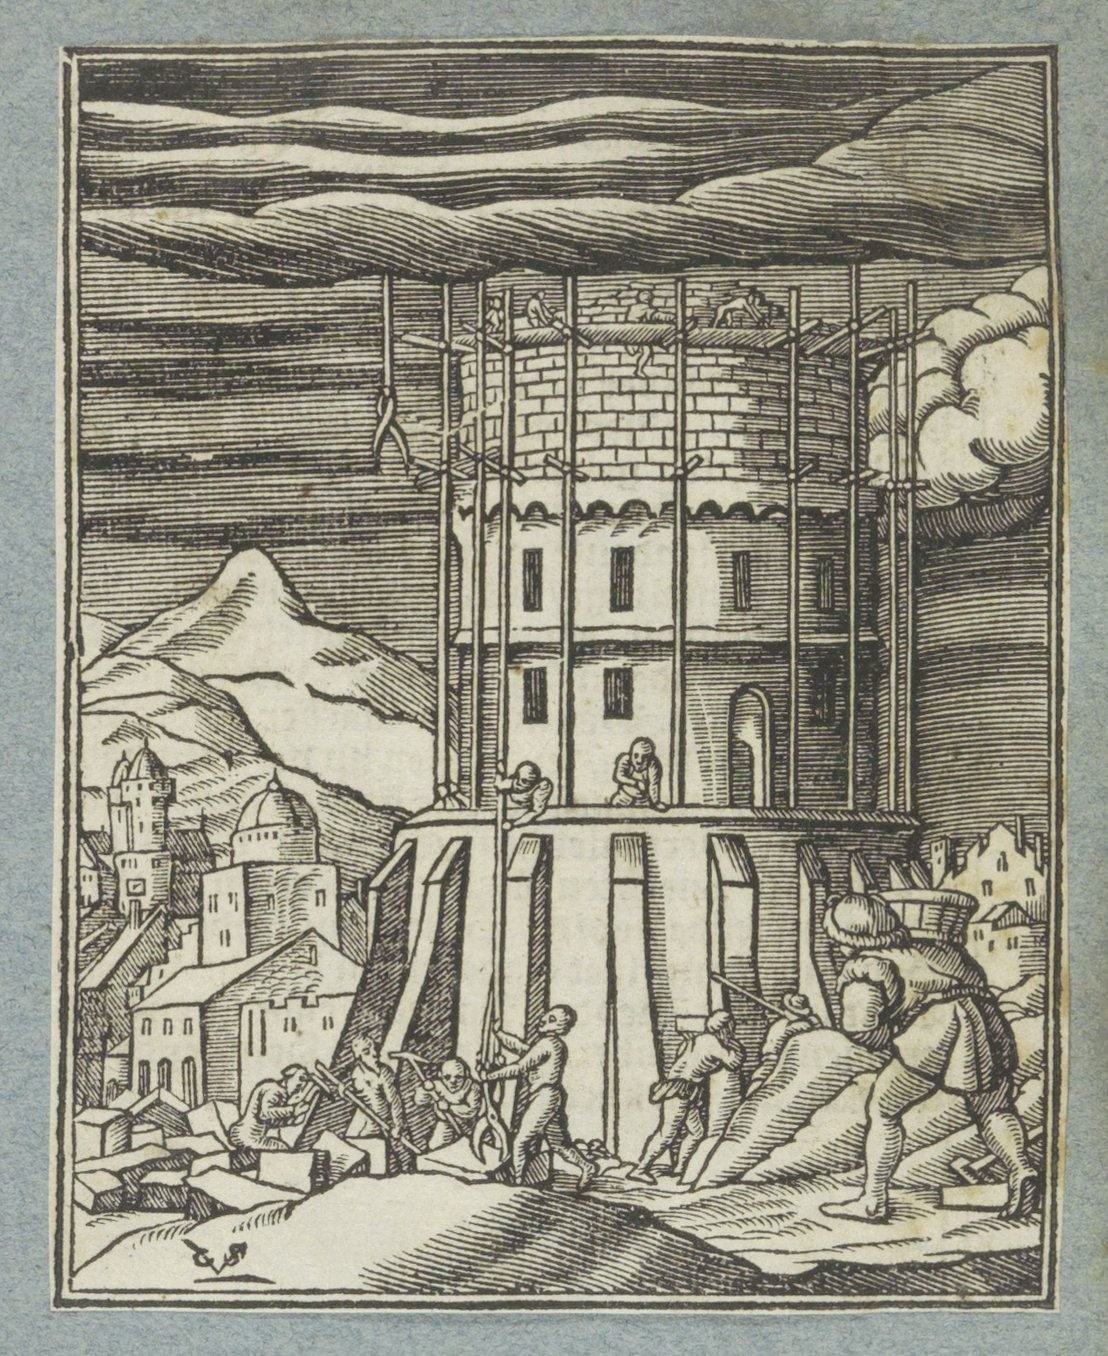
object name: print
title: Bouw van de toren van Babel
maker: pieter jacobsz. paets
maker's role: publisher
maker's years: 1587-1667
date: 1645-1646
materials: paper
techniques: letterpress printing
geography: amsterdam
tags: the building of the tower of babel; nimrod may be present, supervising or assisting the construction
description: De prent werd gemaakt voor de uitgaven van P.J. Paets uit Amsterdam. Ze komt in ieder geval voor in: Bibels Tresoor ofte der zielen lusthof. Amsterdam, P.J. Paets, 1646. Mogelijk ook in: Historien ende Prophetien. [Amsterdam], P.J. Paets, 1645.